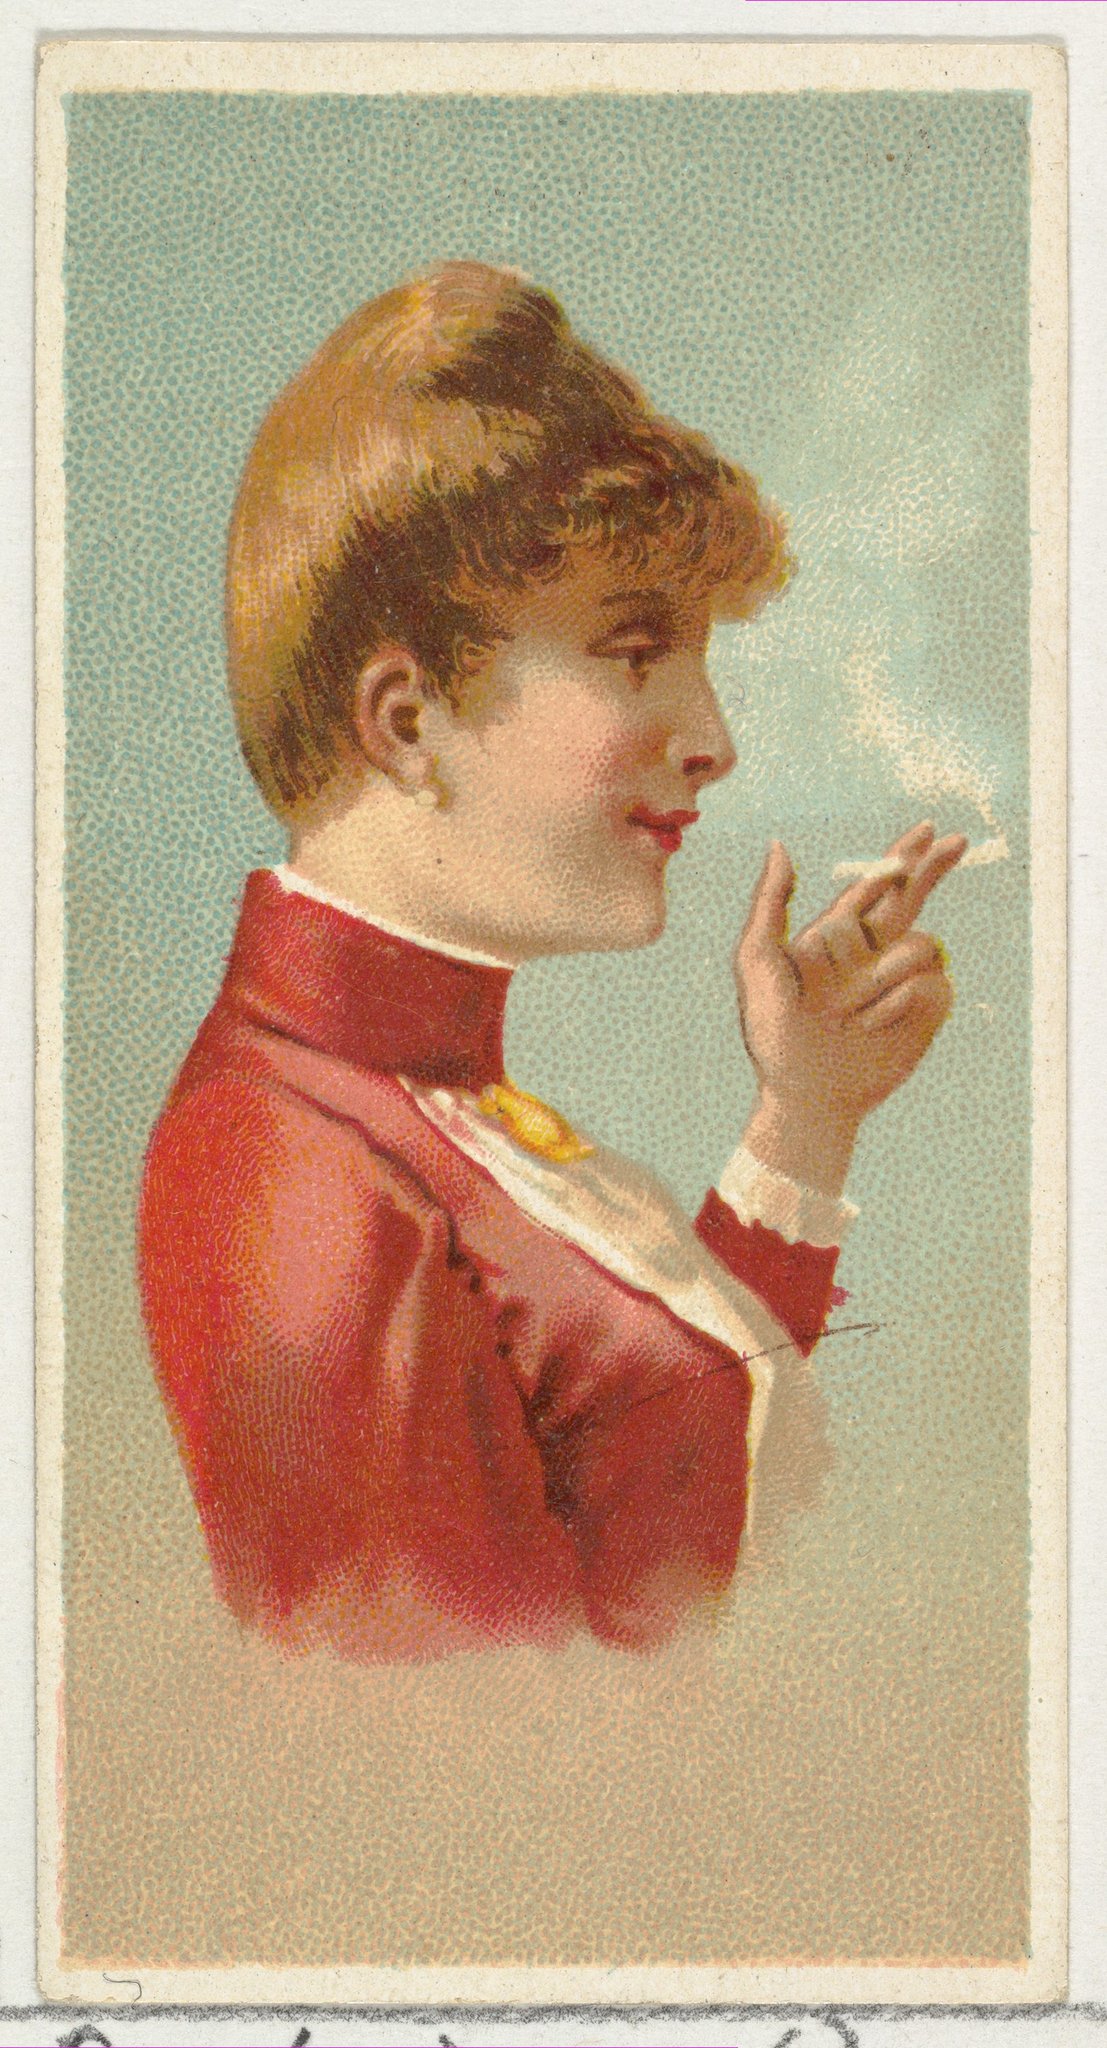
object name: print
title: Russian Lady, printer's sample from World's Smokers series (N33) for Allen & Ginter Cigarettes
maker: allen & ginter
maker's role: publisher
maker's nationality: american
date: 1888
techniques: color lithograph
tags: profiles,women,smoking